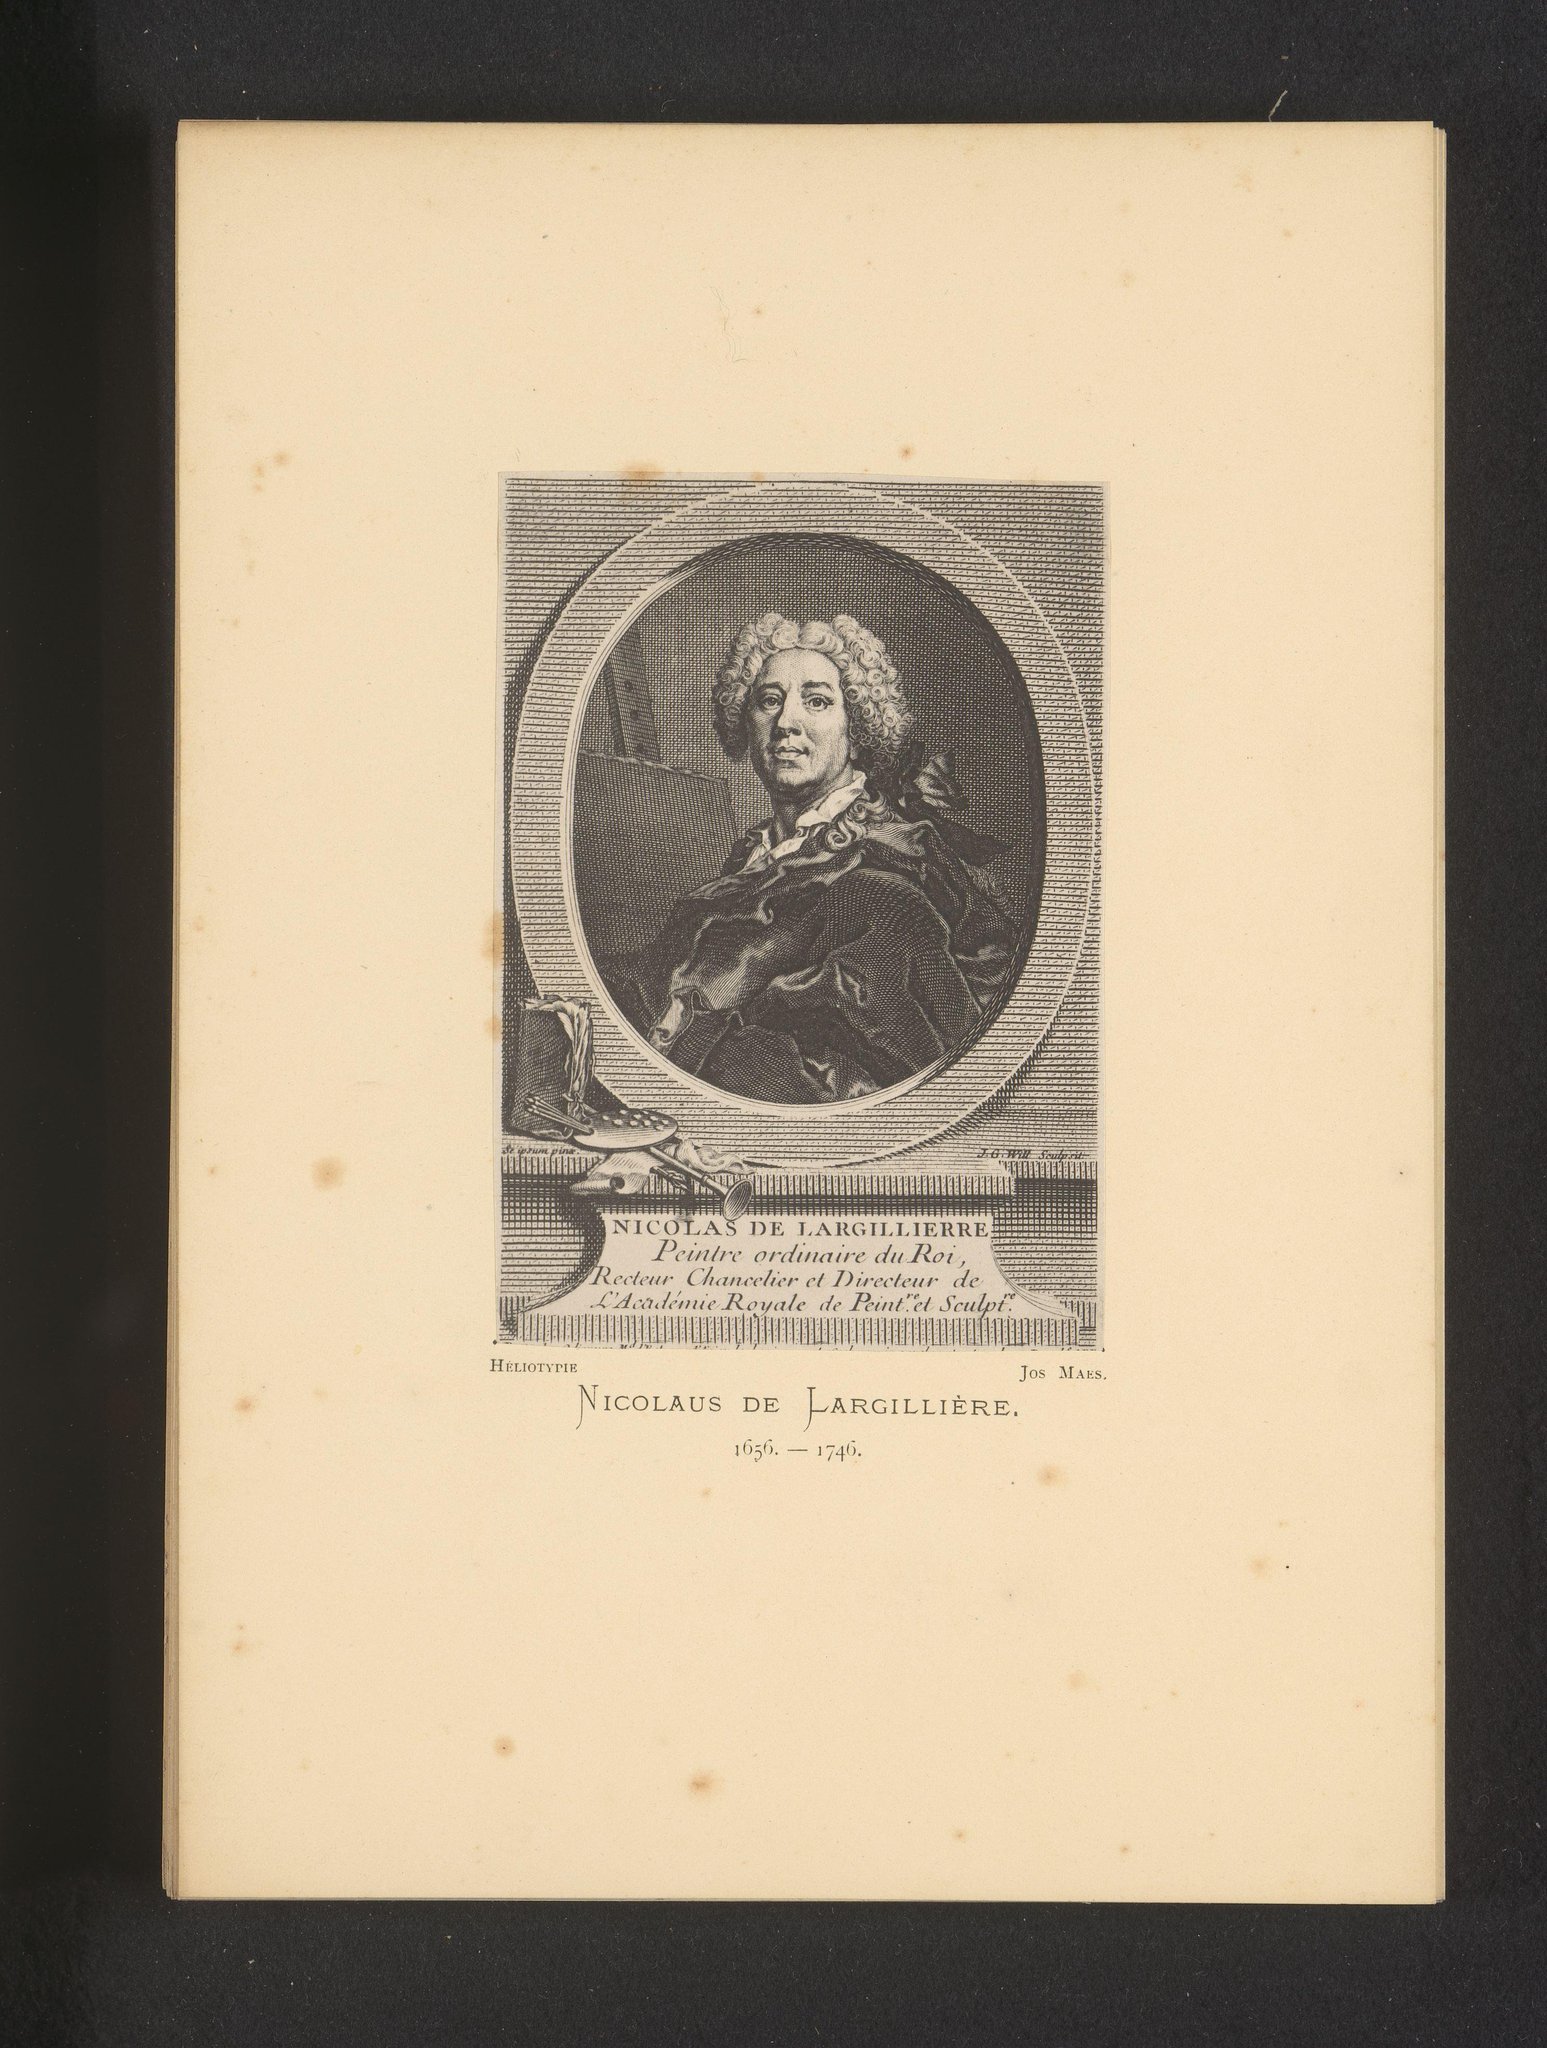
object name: photomechanical print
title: Nicolaus de Largillière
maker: joseph maes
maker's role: fotograaf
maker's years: 1838-1908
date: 1872-1877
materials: cardboard, paper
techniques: photograph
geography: antwerp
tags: paris, painter, draughtsman, nicolas de largillière, historical persons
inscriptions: inscription: ‘1656. - 1746.’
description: Deze prent maakt deel uit van een omslag met 150 prenten en een katern met een lijst van afbeeldingen.